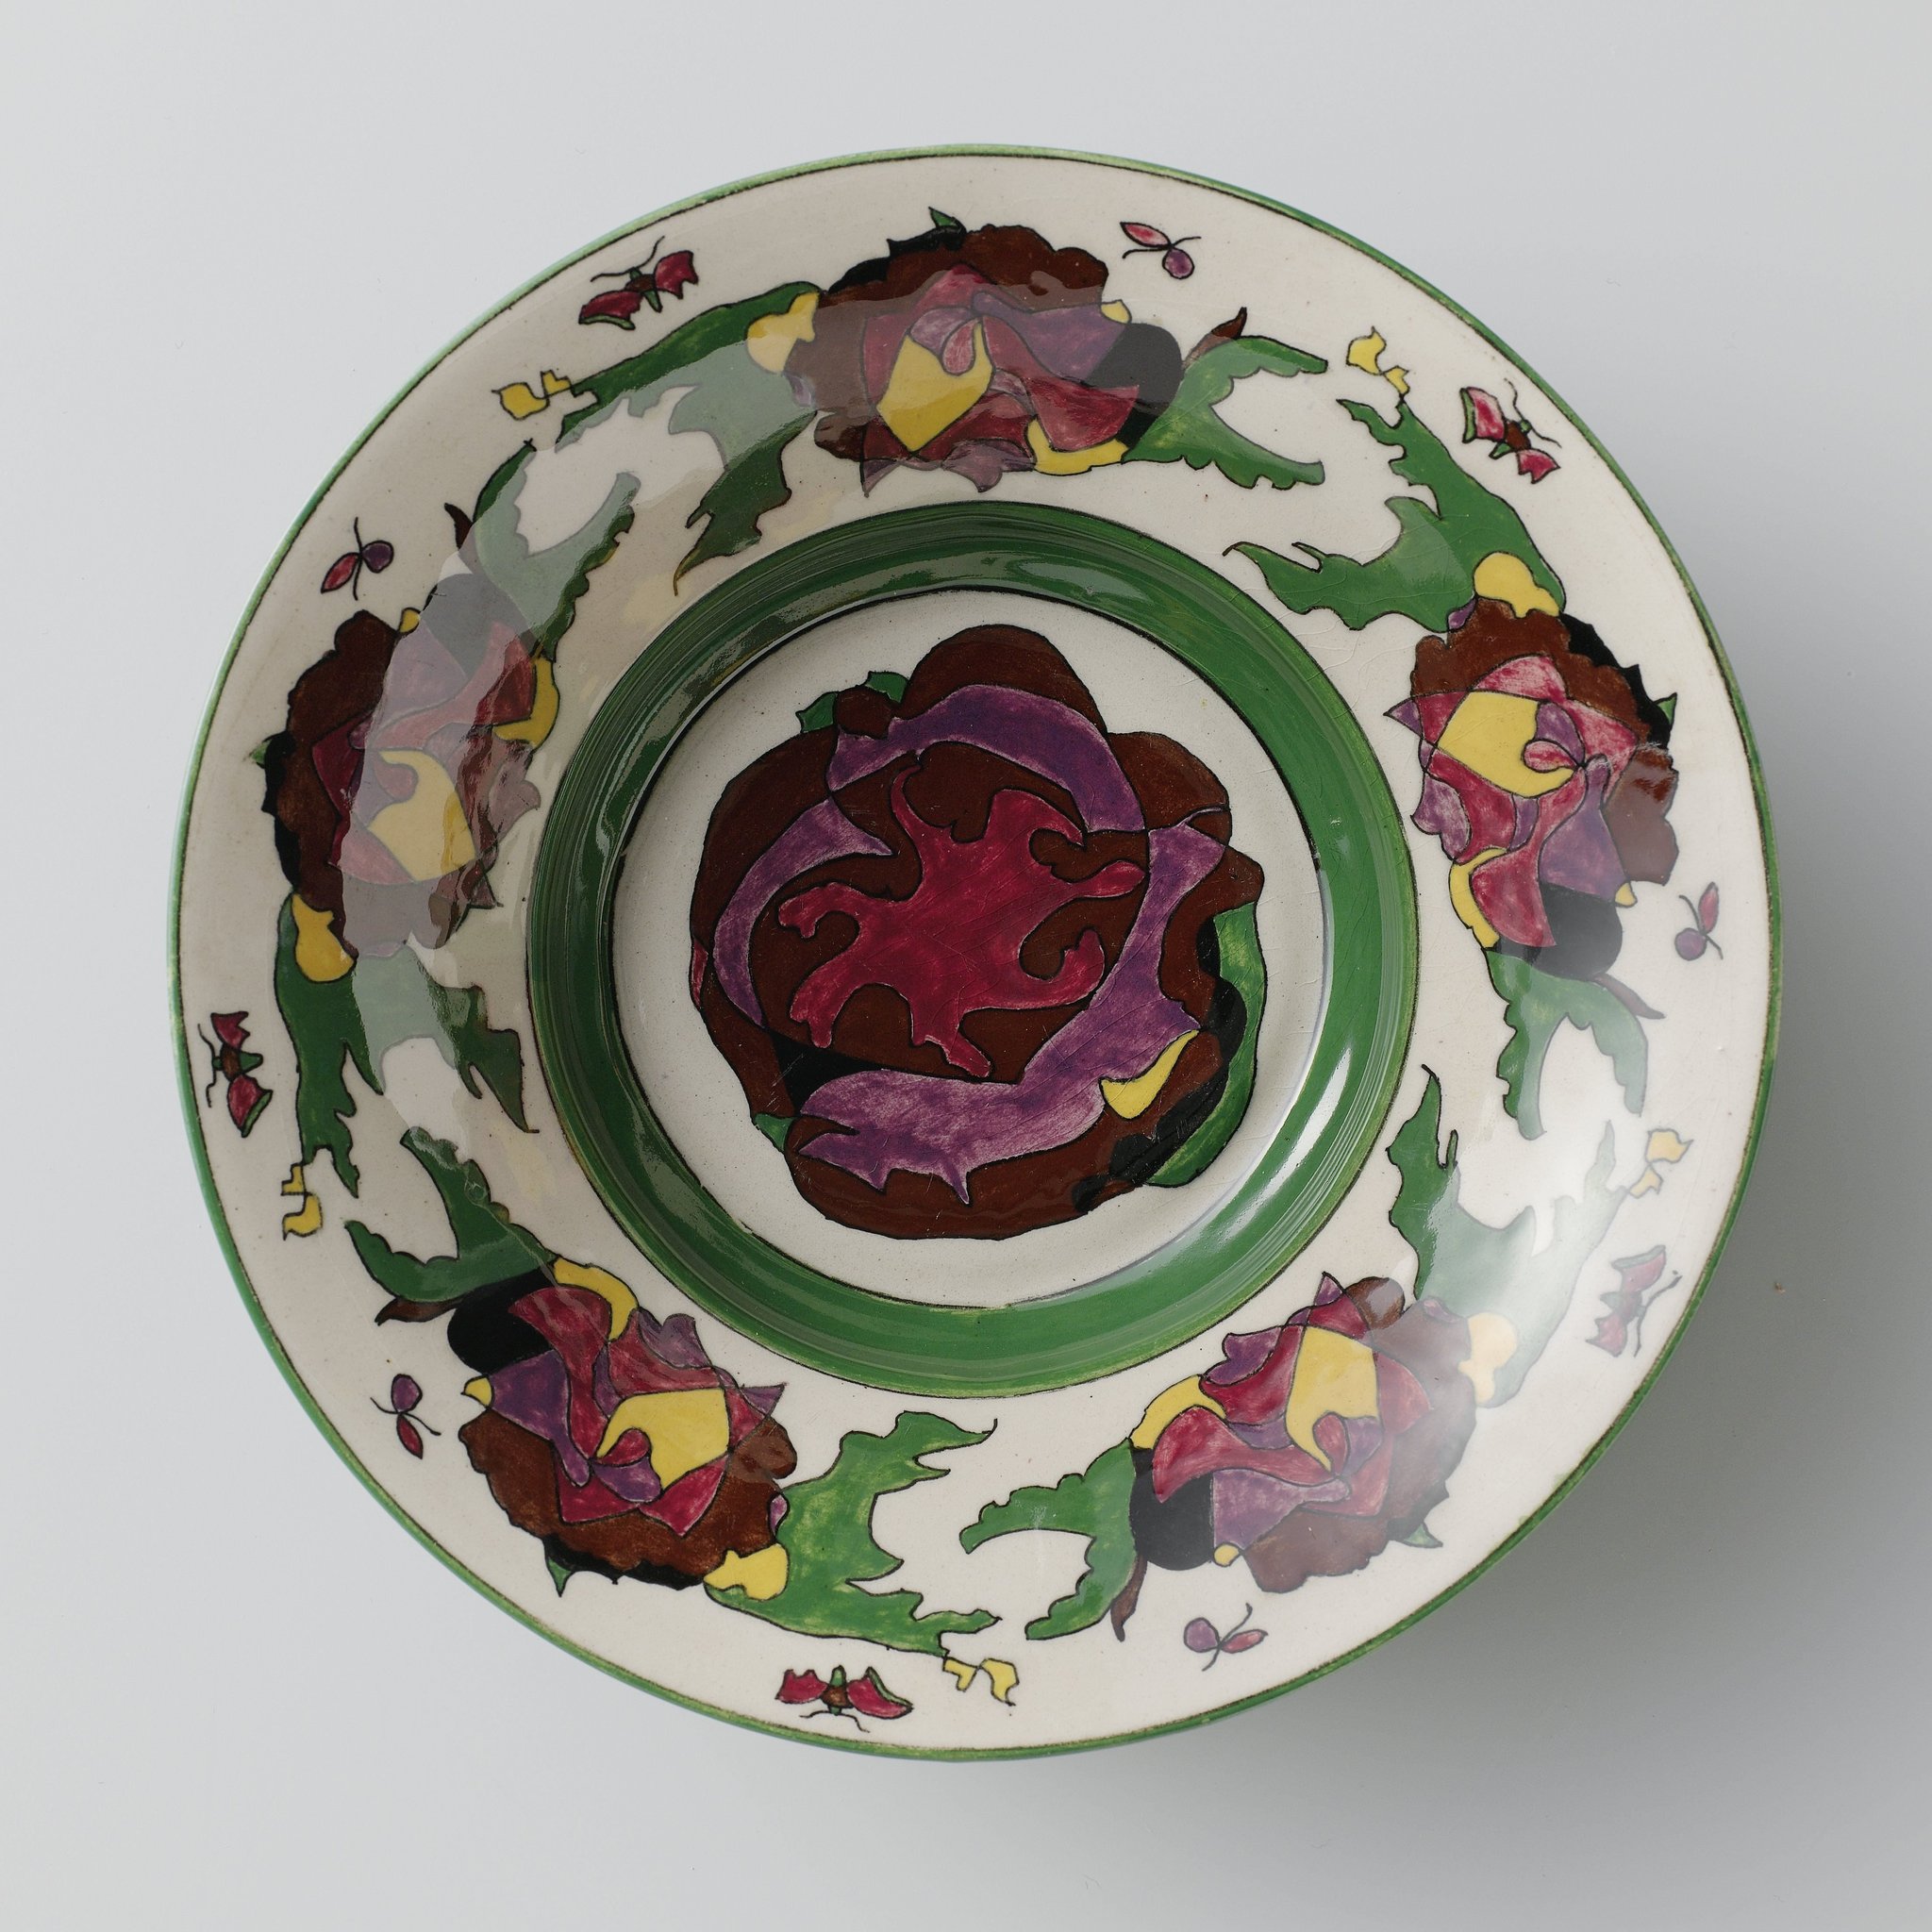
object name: bowl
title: Two bowls with the ‘Nalopend’ (Running) pattern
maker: theo colenbrander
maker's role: draughtsman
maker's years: 1841-1930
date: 1922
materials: earthenware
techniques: painted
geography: arnhem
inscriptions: mark: ‘cirkelstempel, VORM. No. 34. AP. PATR. "B. NALOOPEND" in zwart, ingegrift 34.’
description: Twee kommen van aardewerk, veelkleurig beschilderd met het decor 'B. Naloopend'. De buitenkant en een brede band rondom de bodem in groen. Gemerkt met: cirkelstempel, VORM. No. 34. AP. PATR. "B. NALOOPEND" in zwart, ingegrift 34.